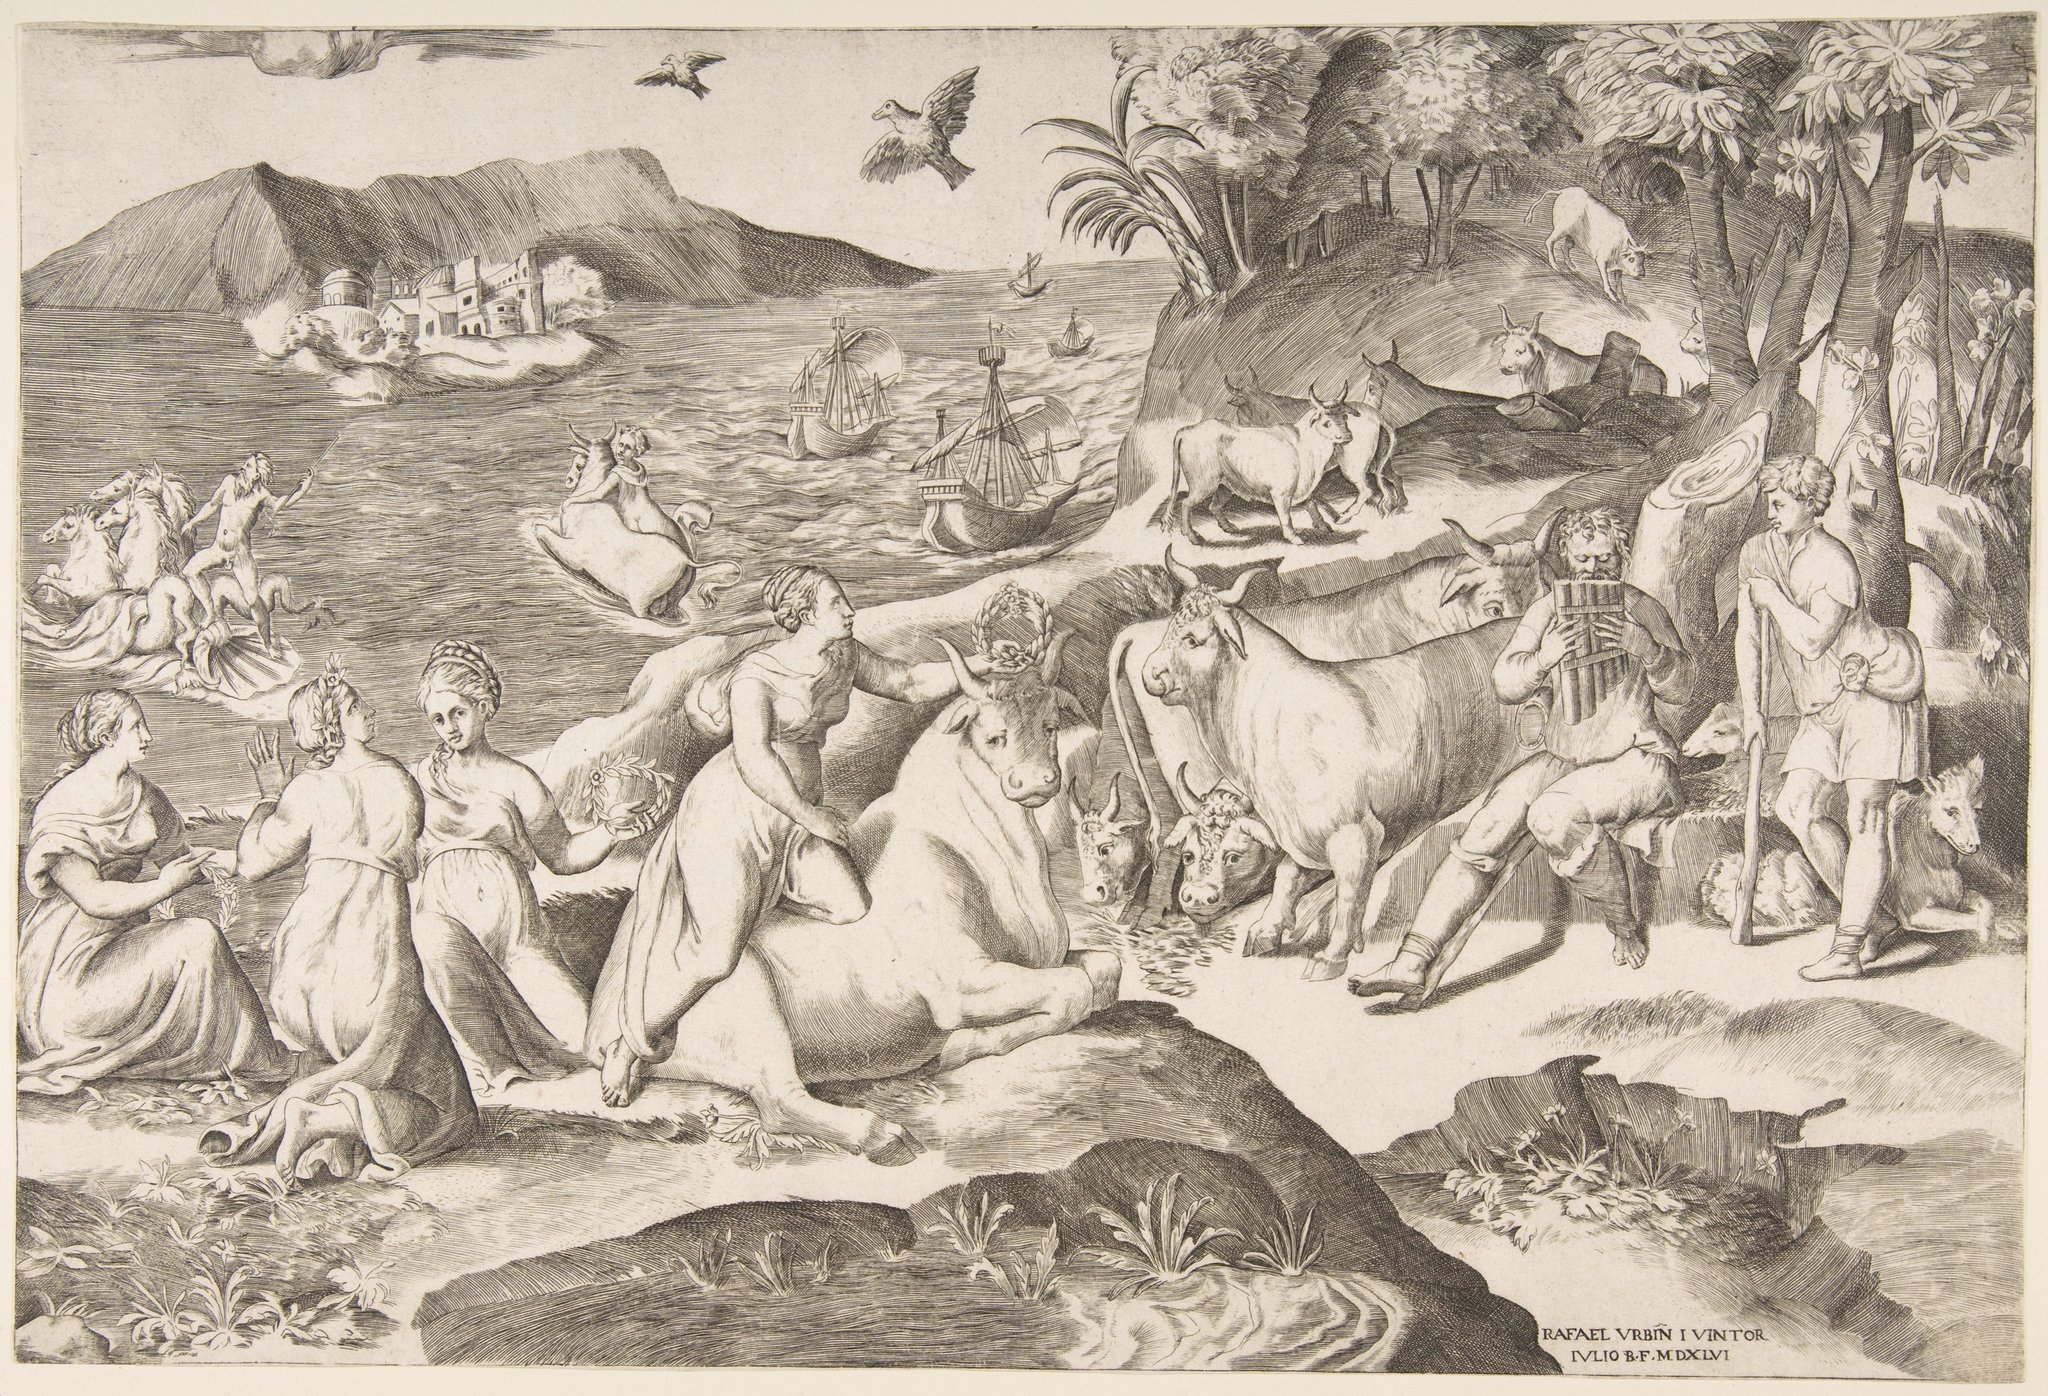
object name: print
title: The Rape of Europa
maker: giulio bonasone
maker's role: artist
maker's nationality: italian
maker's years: 1510-1576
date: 1546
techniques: engraving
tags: musical instruments,animals,birds,men,europa